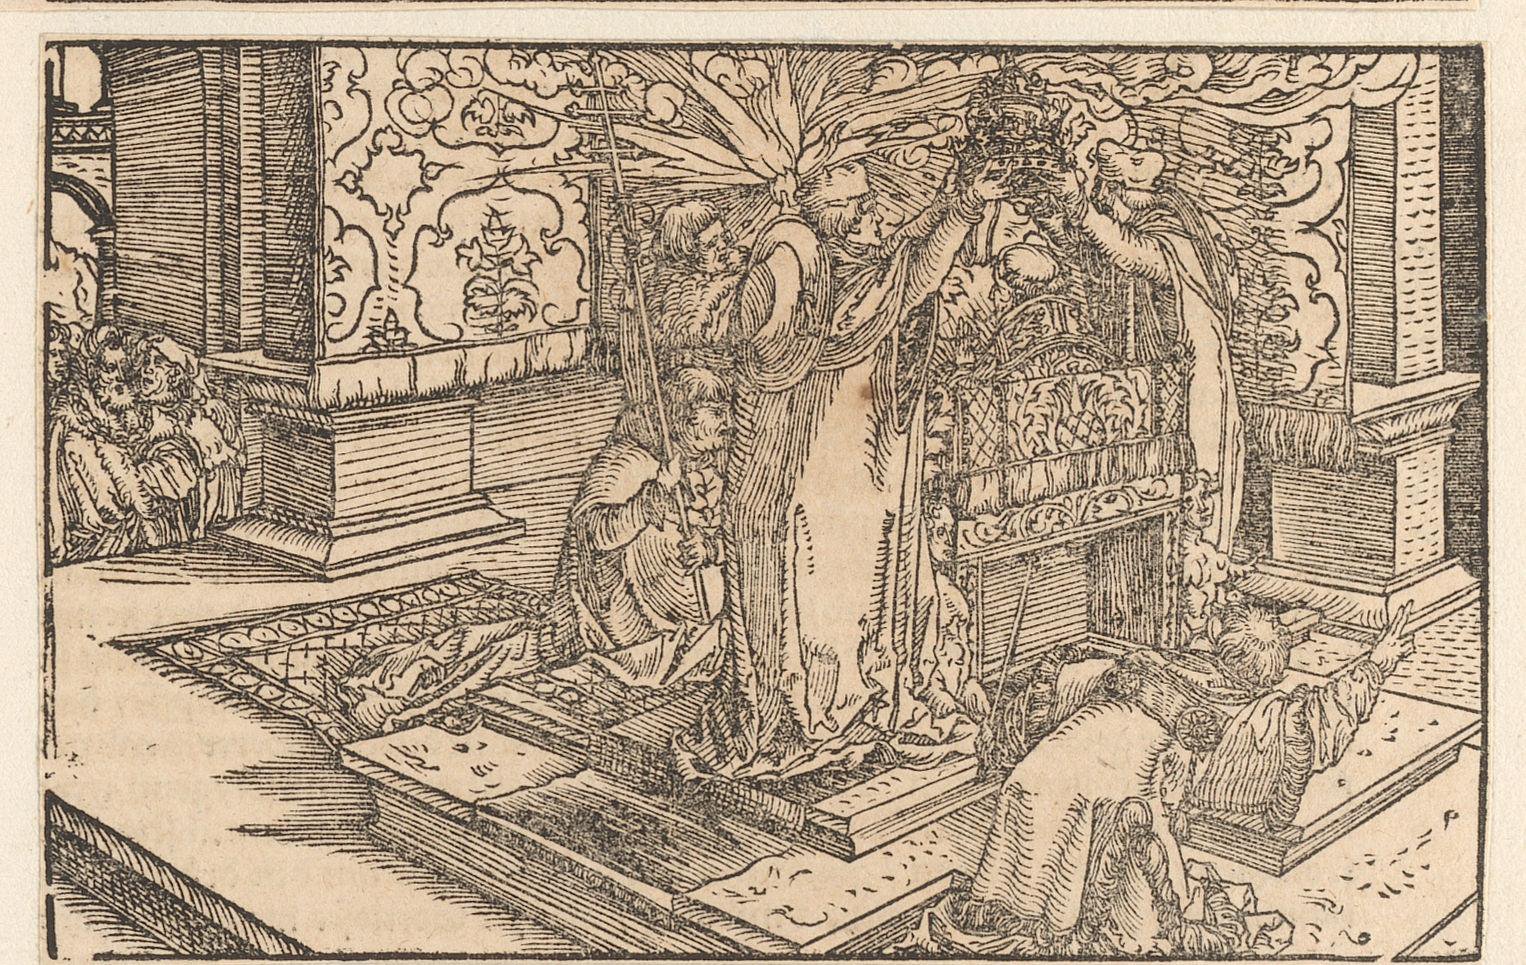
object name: print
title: Engel en knielende monnik bidden bij het altaar waar een priester de hostie wijdt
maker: Anonymous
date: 1514-1532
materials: paper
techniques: letterpress printing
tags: bread, host, public worship and liturgy of the christian churches, angels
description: Deze prent is gebruikt in: Petrarca, Francesco. Von der Artzney bayder Glück, des guten und widerwertigen: unnd weß sich ain yeder inn Gelück und Unglück halten sol (...). Augsburg: Heinrich Steiner, 1532. Deze uitgave is ook bekend onder de titel 'Trostspiegel in Glück und Unglück'.